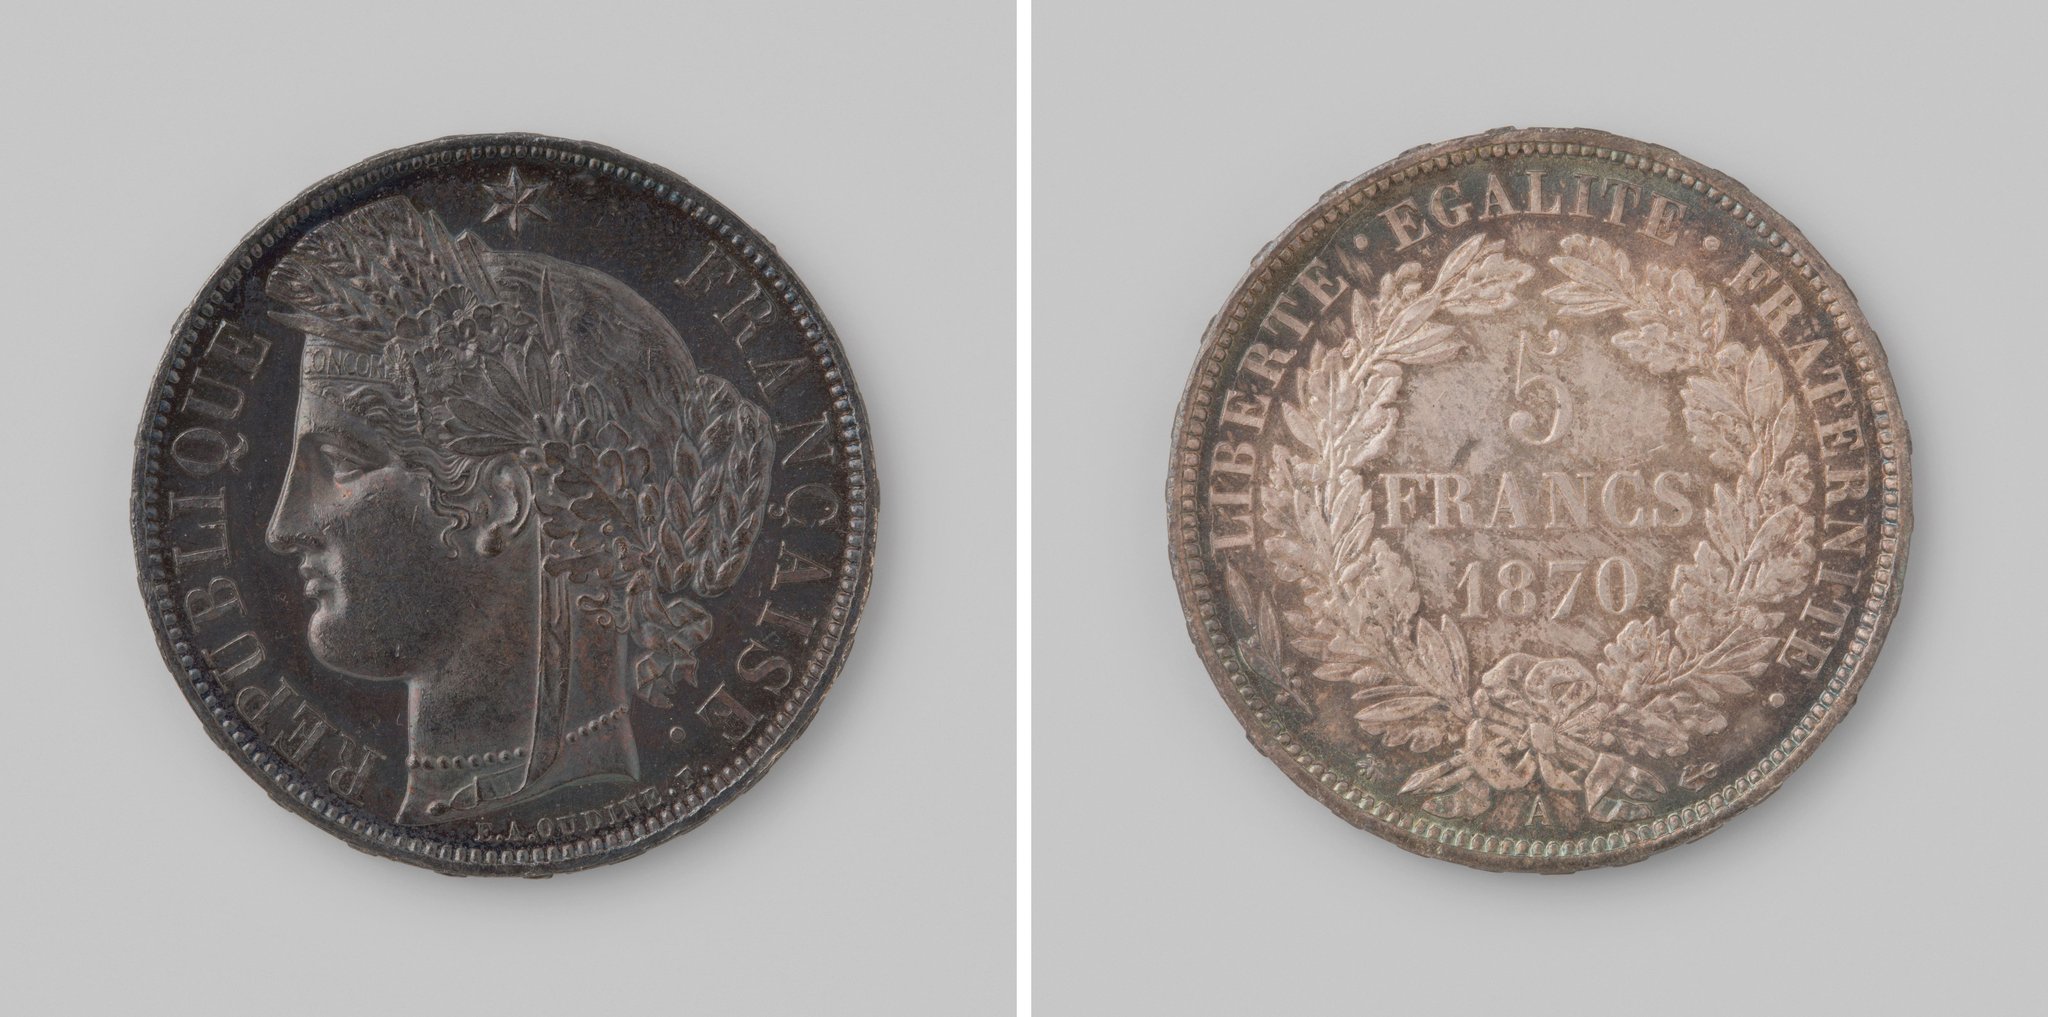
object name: coin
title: Frankrijk, Derde Republiek, 5 francs,1870 A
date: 1870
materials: silver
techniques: striking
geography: paris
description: Zilveren munt. Voorzijde: portret van een vrouw met krans en diadeem naar links. Bovenaan ster. Keerzijde: binnen twee samengebonden takken waarde-aanduiding in twee regels, waaronder jaartal. Onderaan de letter A [=Parijs]. Opliggend randschrift.